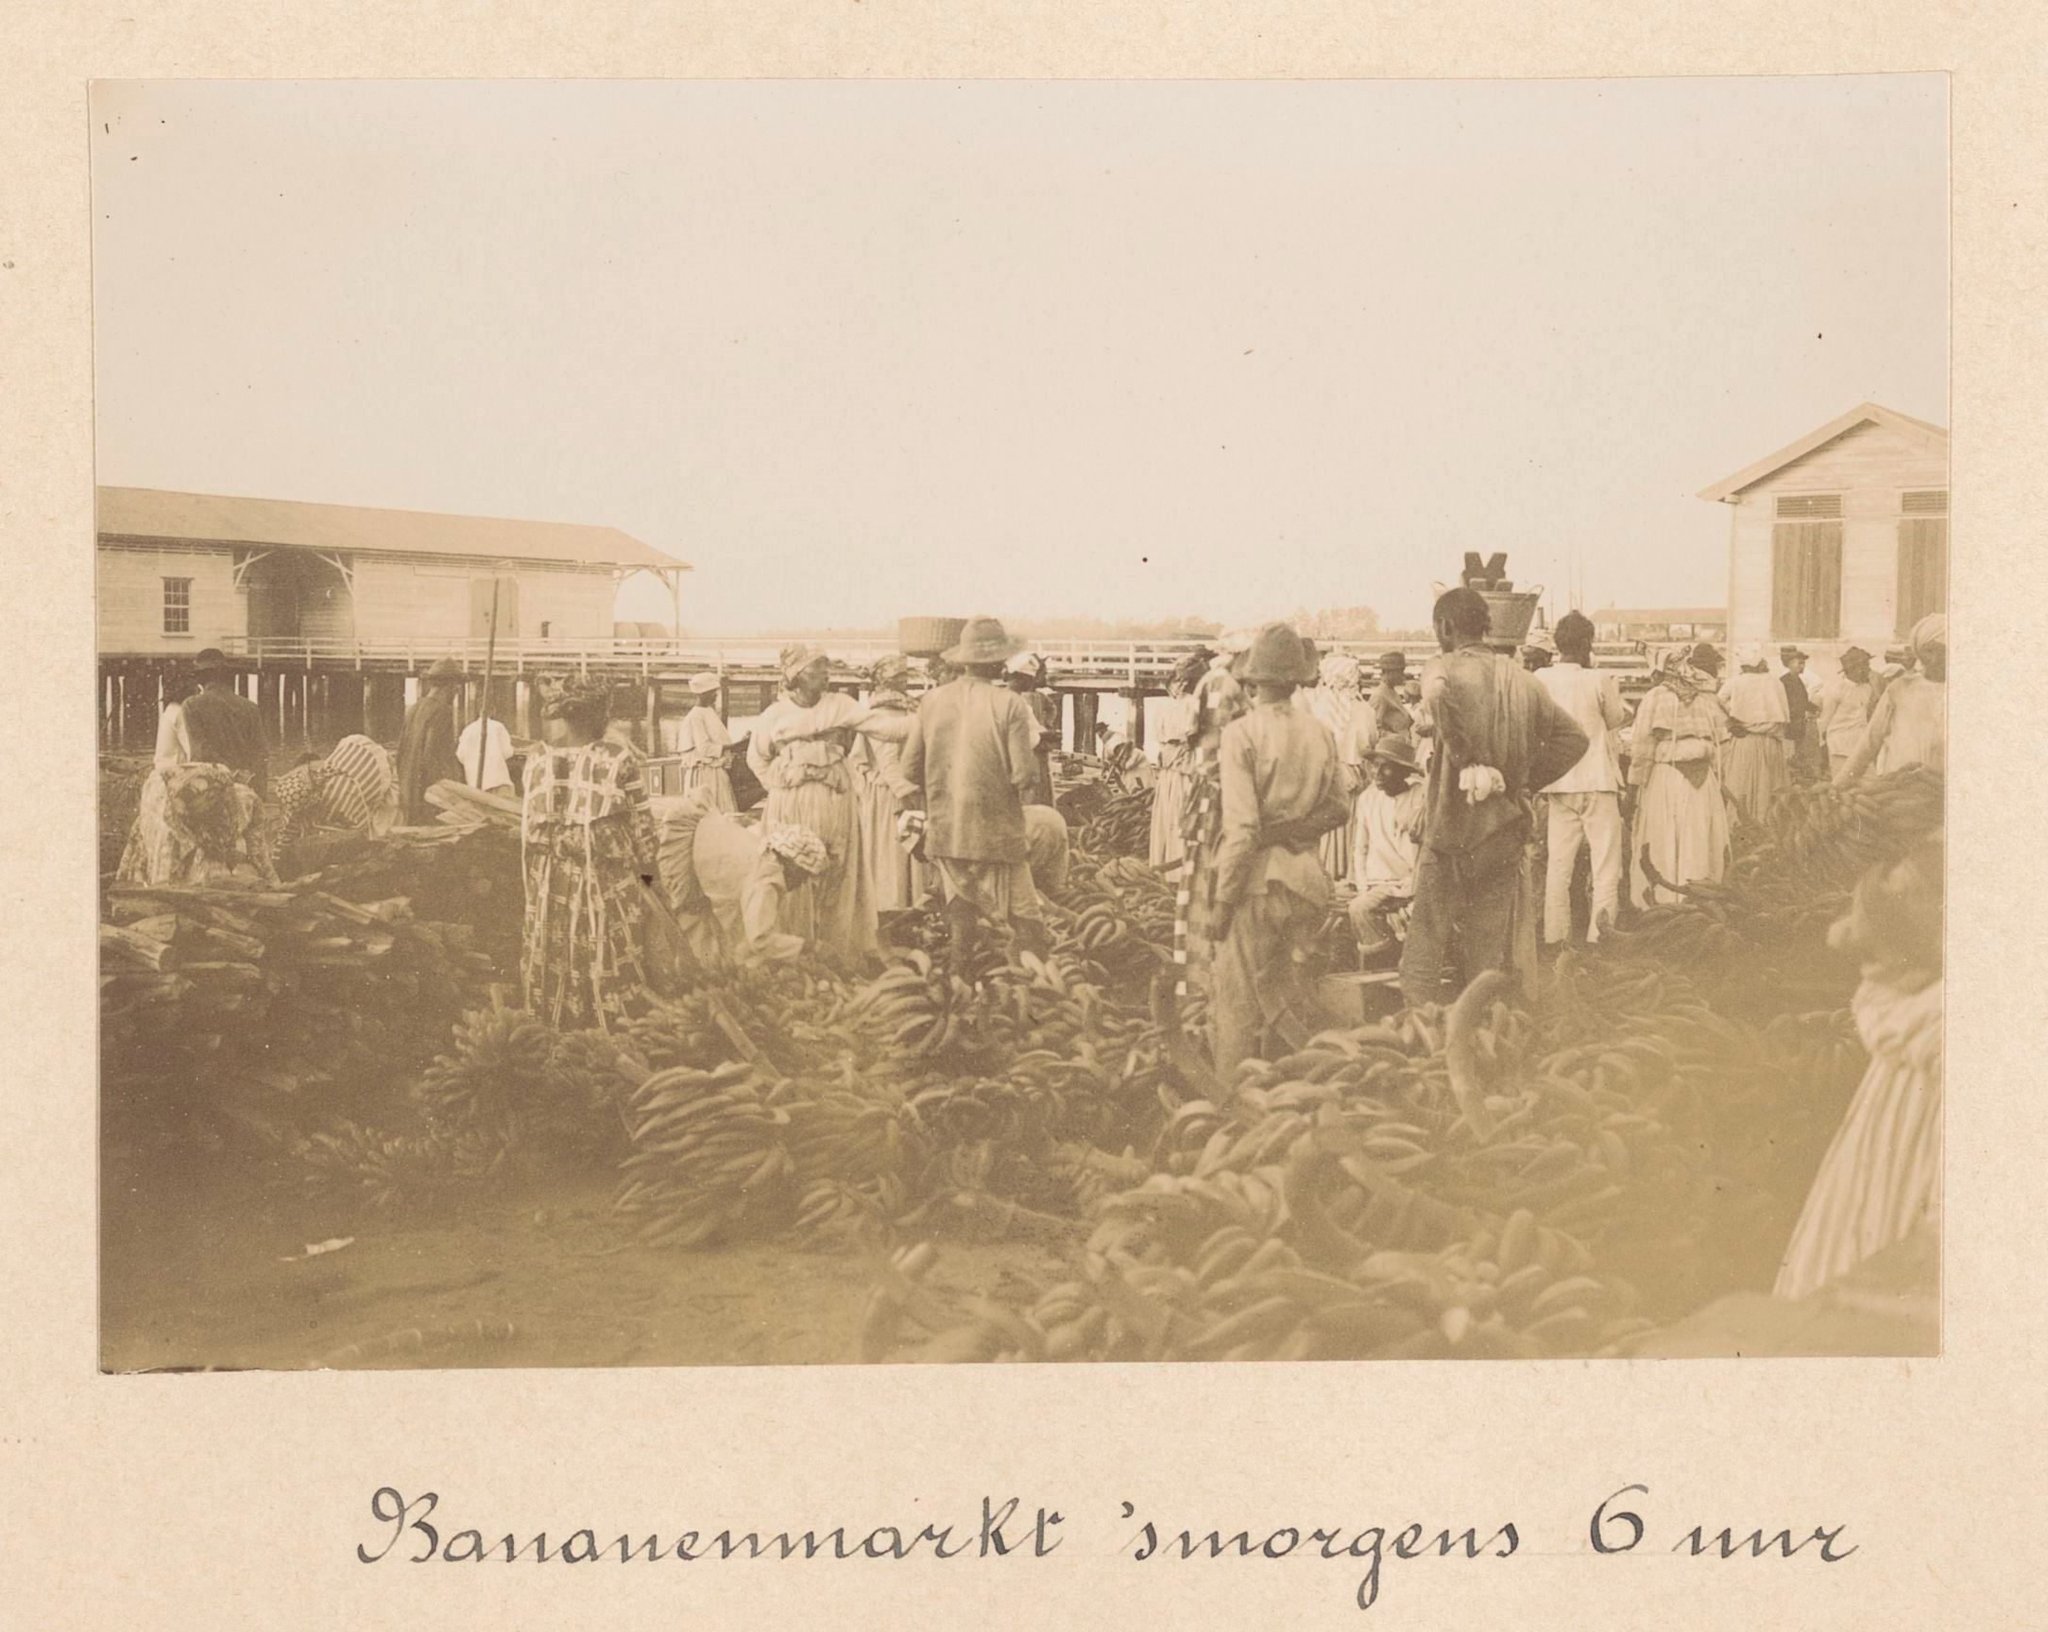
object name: photograph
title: Bananenmarkt 's morgens 6 uur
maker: eugen klein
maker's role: fotograaf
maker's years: 1869-1927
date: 1900-1905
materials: cardboard, photographic support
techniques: gelatin silver print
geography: paramaribo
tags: paramaribo (stad)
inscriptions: inscription: ‘Paramaribo / Bananenmarkt 's morgens 6 uur’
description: Een markt waar 's ochtends vroeg bananen worden verkocht, te Paramaribo. Onderdeel van een groep van 44 foto's van Paramaribo, Suriname en Curaçao, ca. 1900-1905, opgeplakt op kartons en voorzien van opschriften.